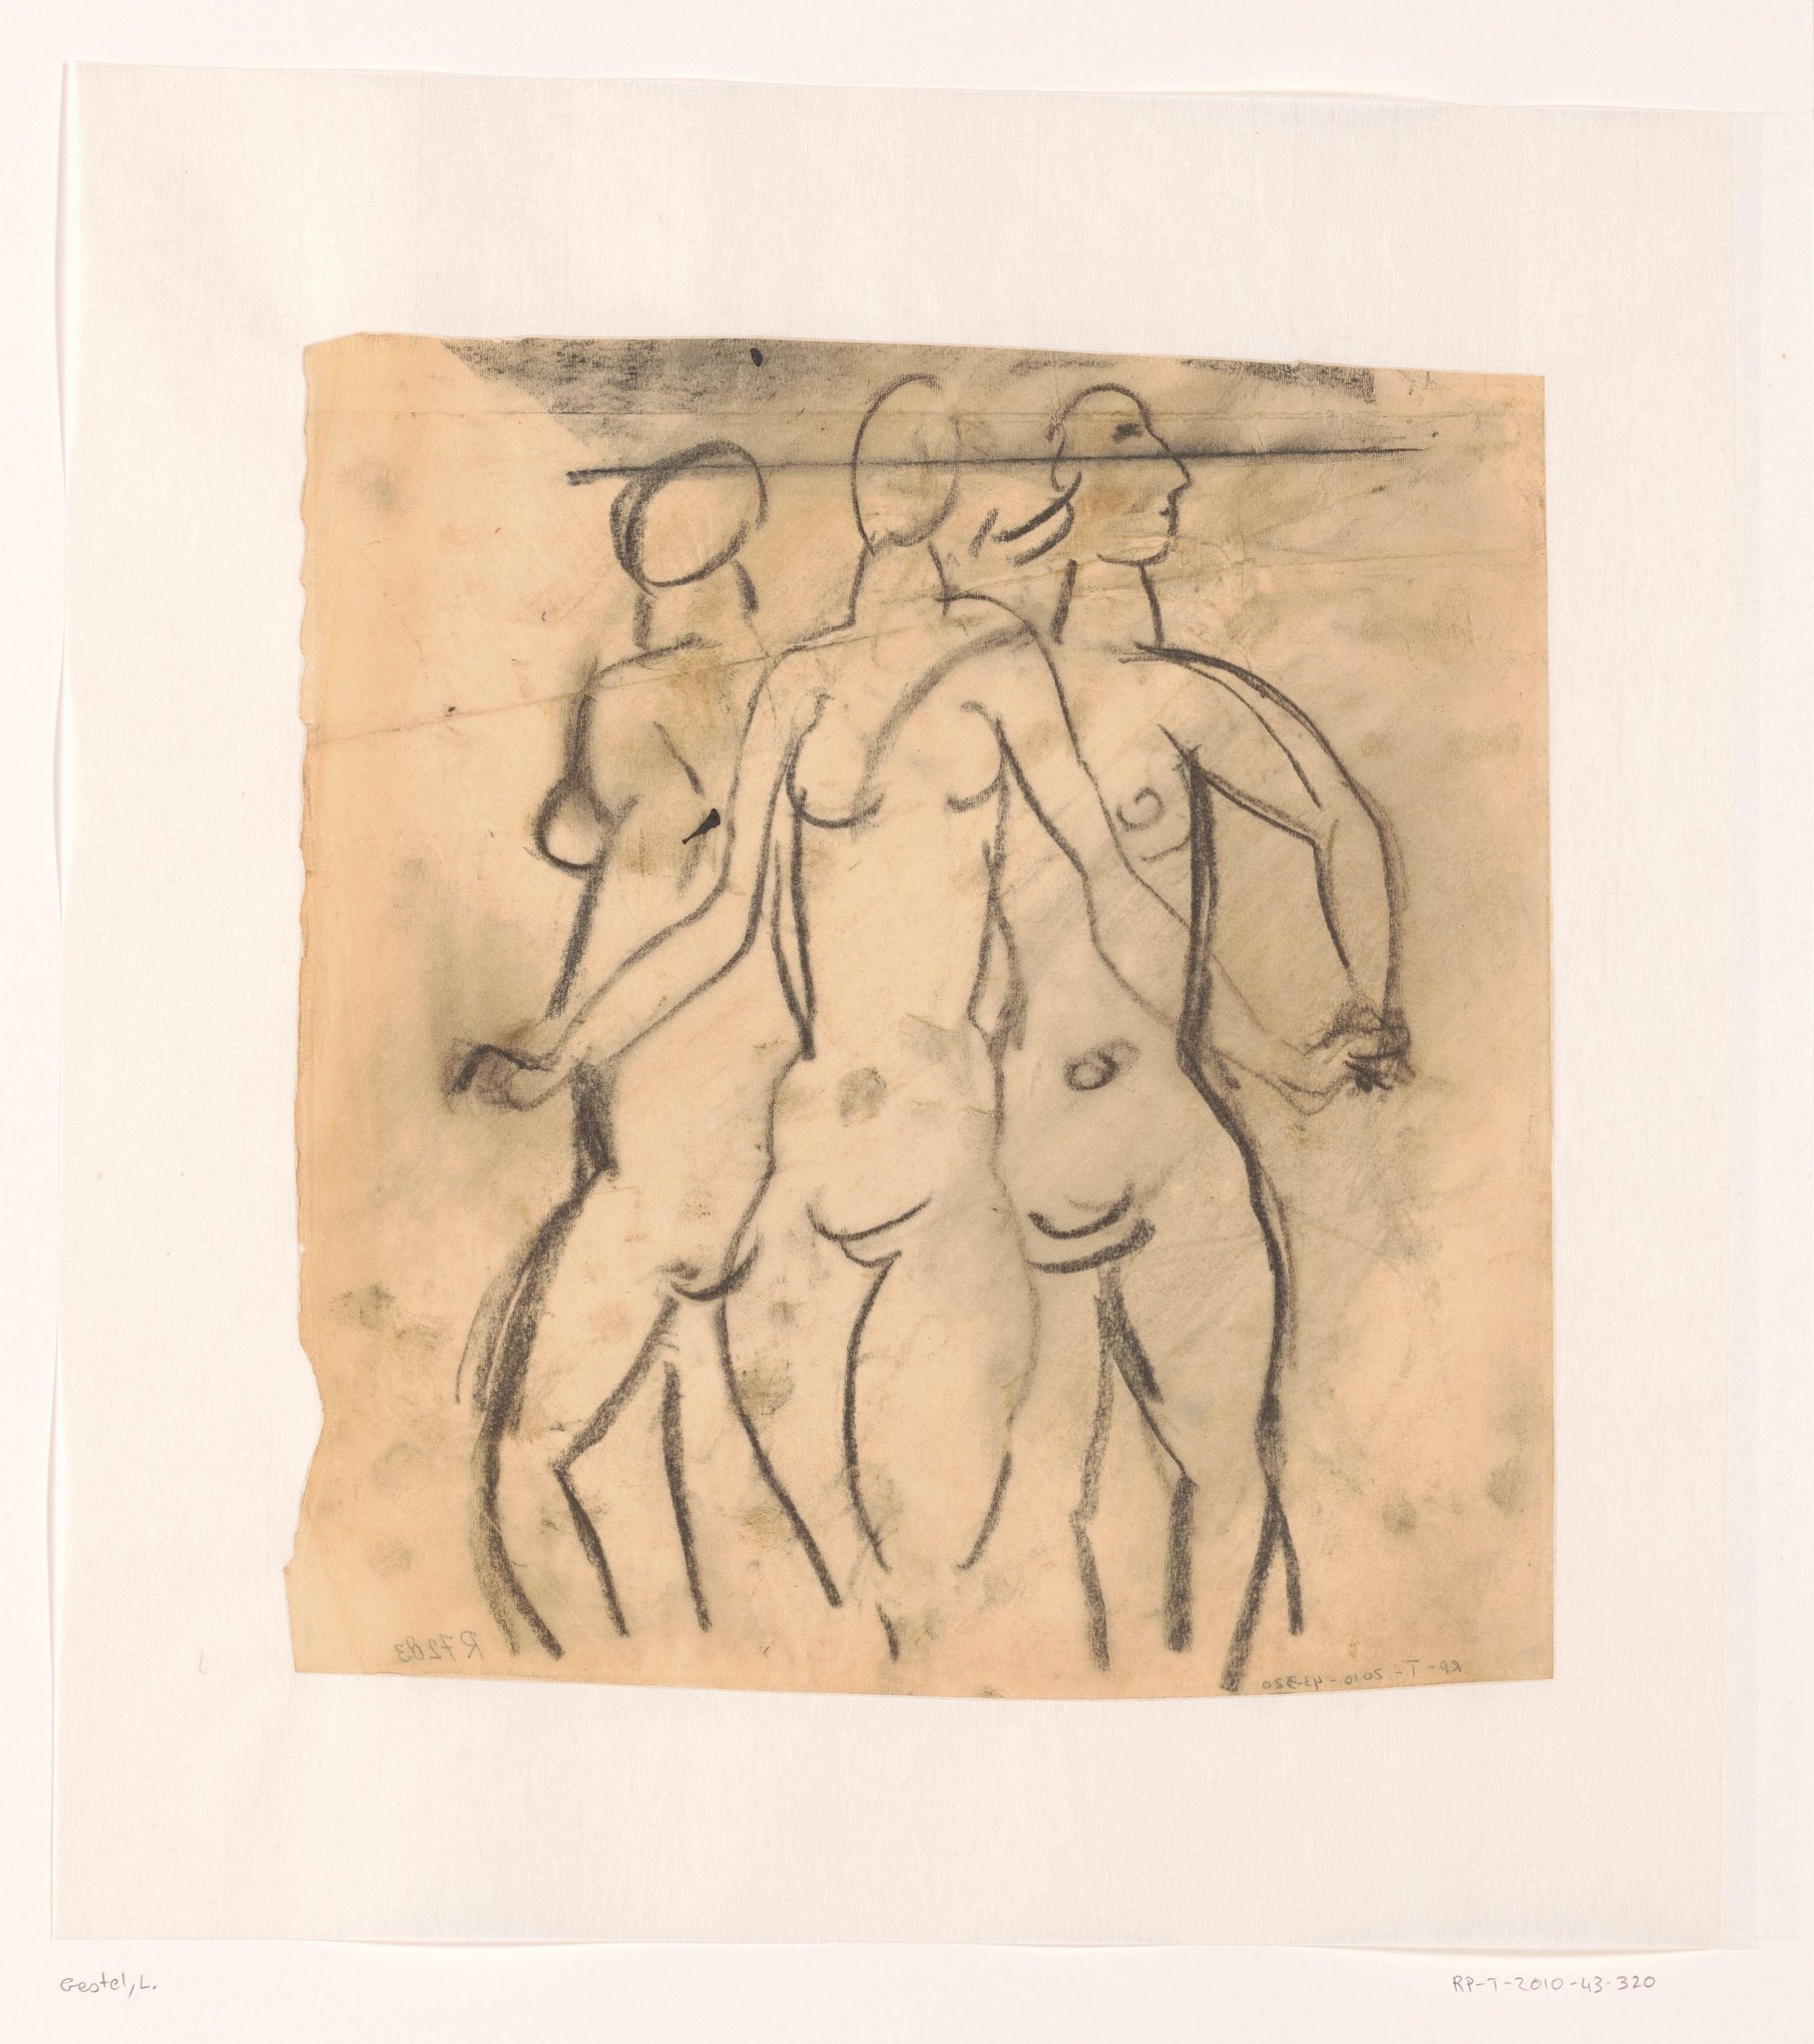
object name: study for binding design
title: Boekomslag Paul Fierens 'L'Art Hollandais contemporain (ontwerp met drie gratiën)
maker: leo gestel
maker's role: draughtsman, print maker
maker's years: 1881-1941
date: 1933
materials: chalk, paper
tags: graces (charites), generally three in number; 'gratie' (ripa), book-cover, binding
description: Drie staande naakte vrouwen die elkaars handen vasthouden, de linker op de rug gezien, alleen de vrouw rechts met gezichtskenmerken.